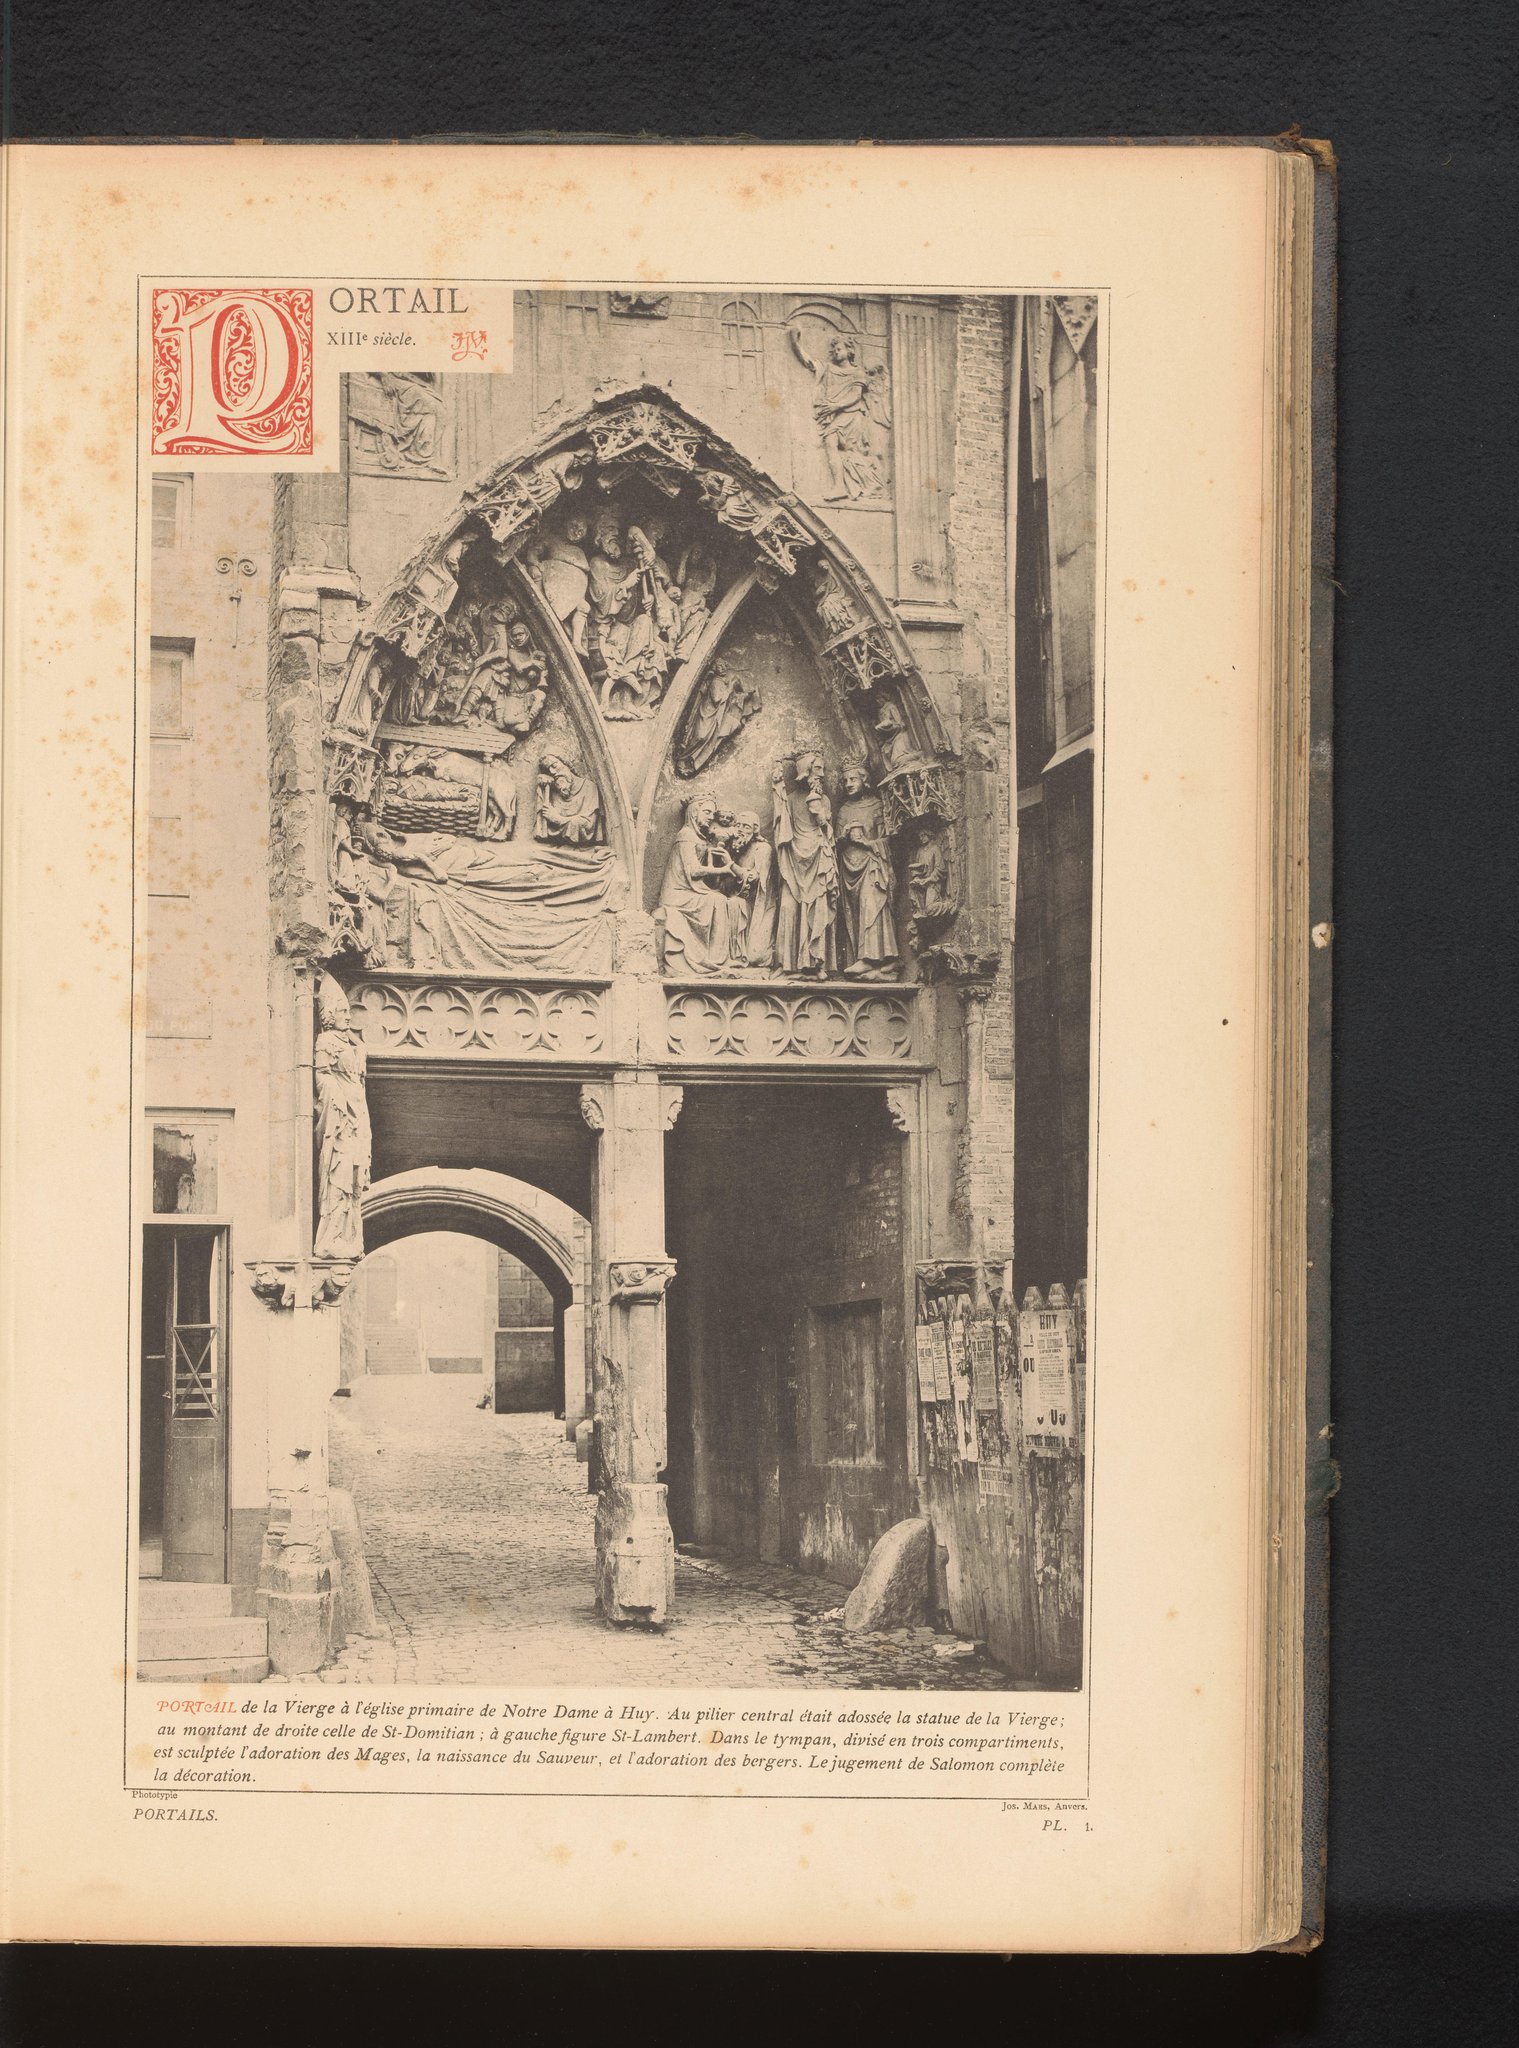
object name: photomechanical print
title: Poort van de Collegiale kerk Onze-Lieve-Vrouw en Domitianus van Hoei, België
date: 1882-1887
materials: paper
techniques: photograph, photolithography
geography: antwerp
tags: parts of church exterior and annexes: portal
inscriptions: inscription: ‘PORTAIL de la (...)’, monogram: ‘JJvY’, inscription: ‘PORTAILS. - PL. 1.’